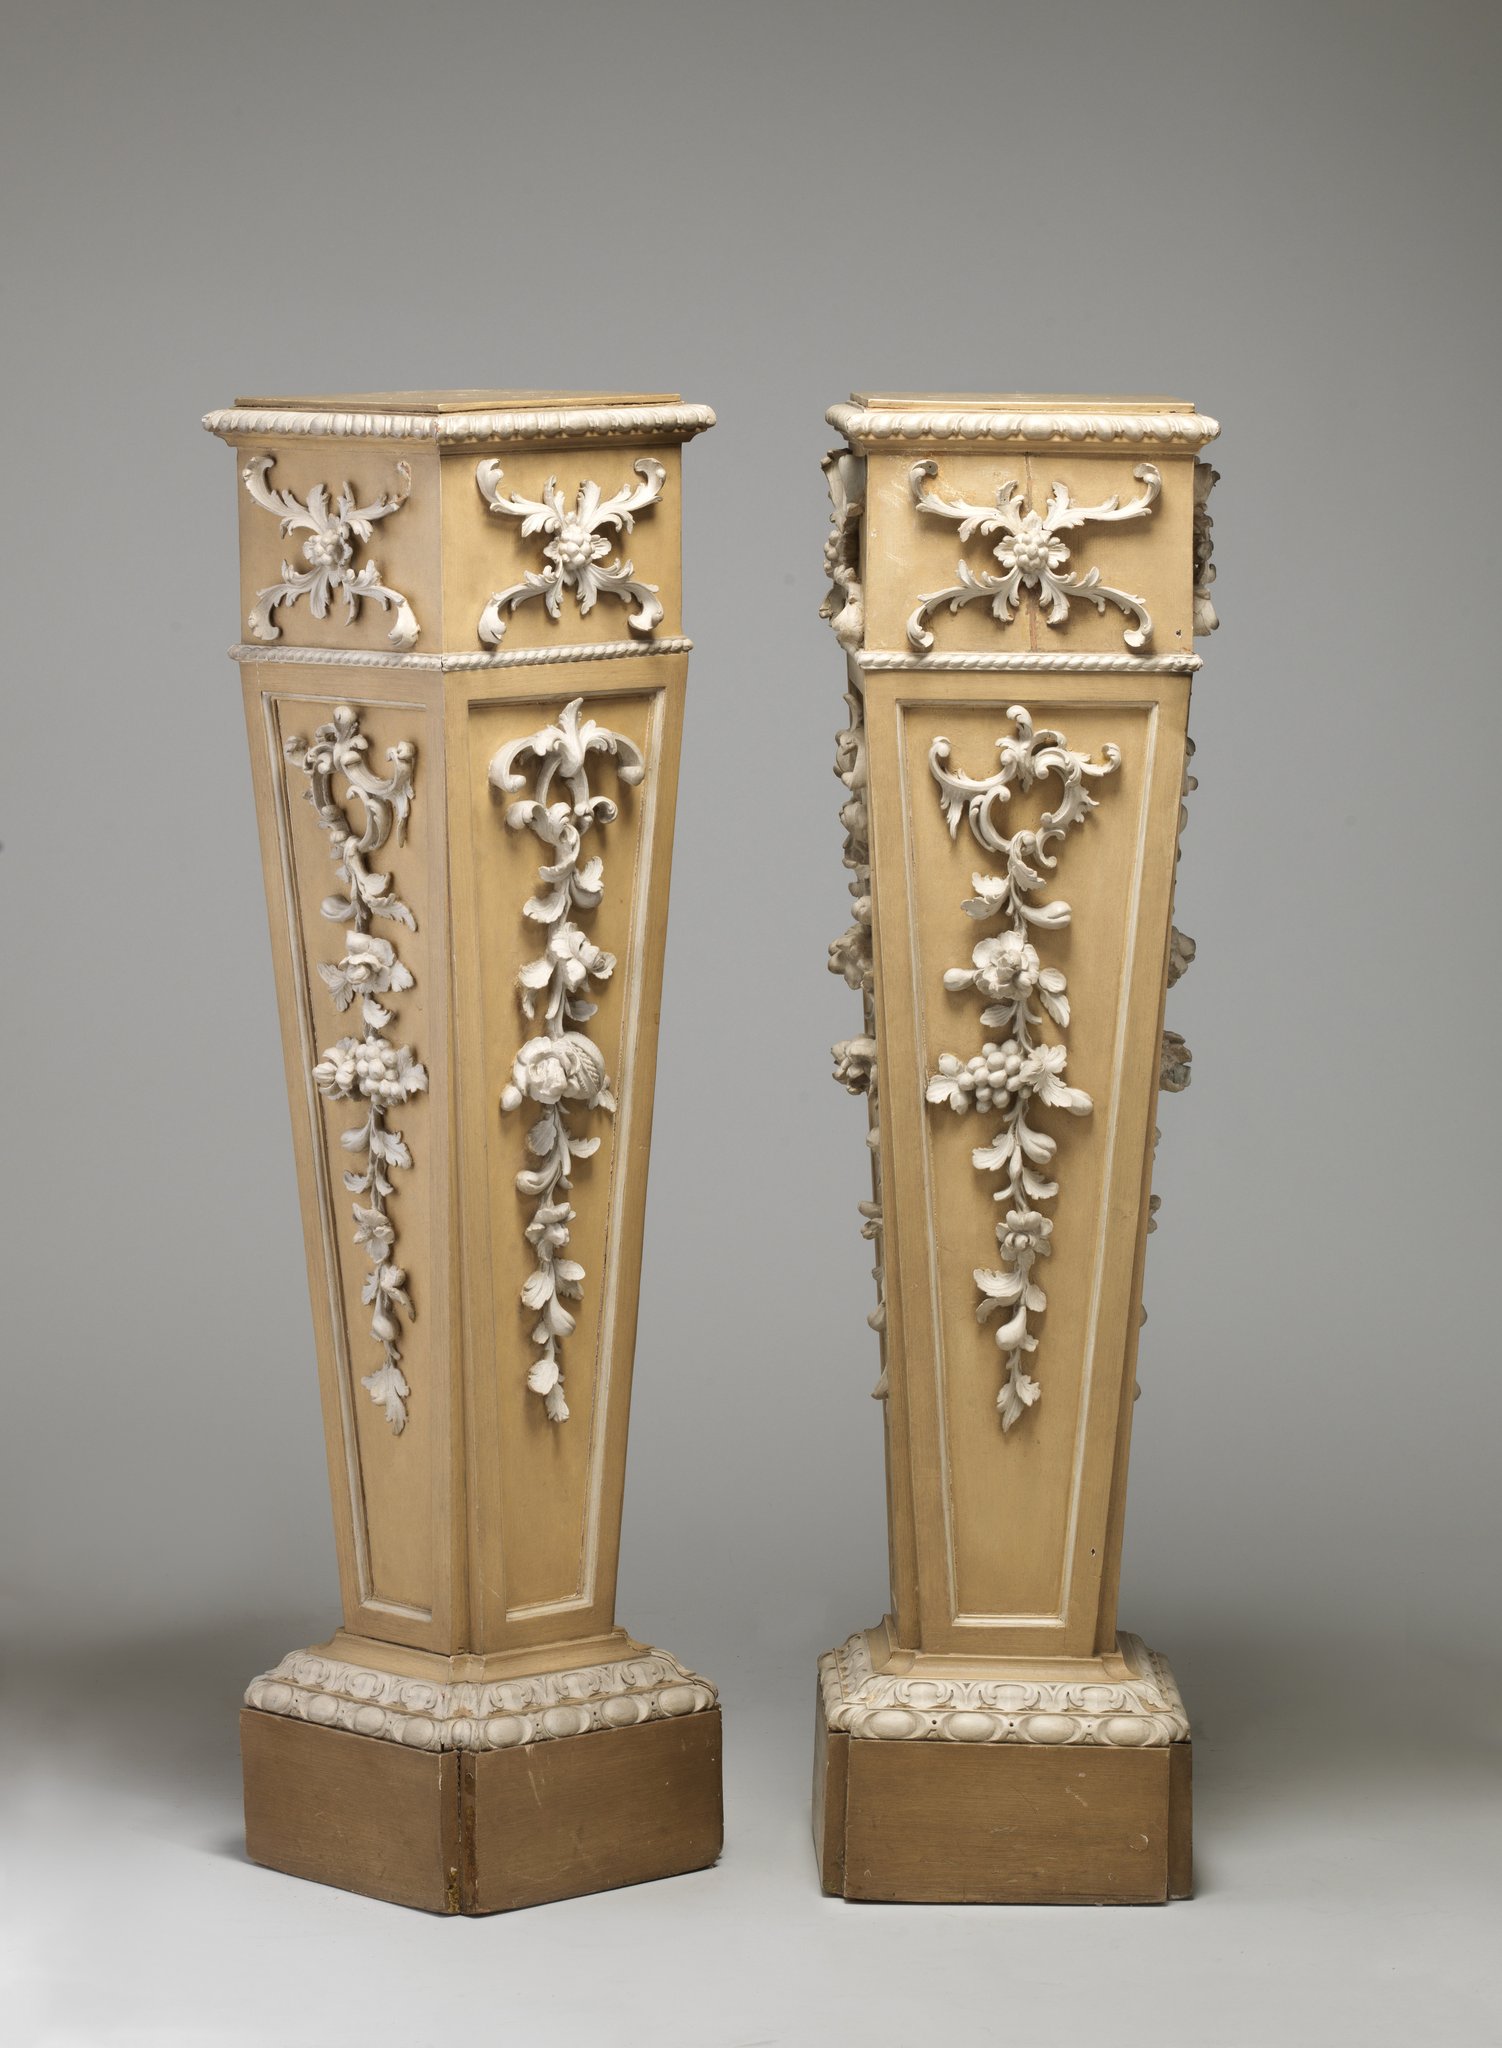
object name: pedestal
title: Pair of pedestals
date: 1760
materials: wood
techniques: painting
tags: fruit,flowers